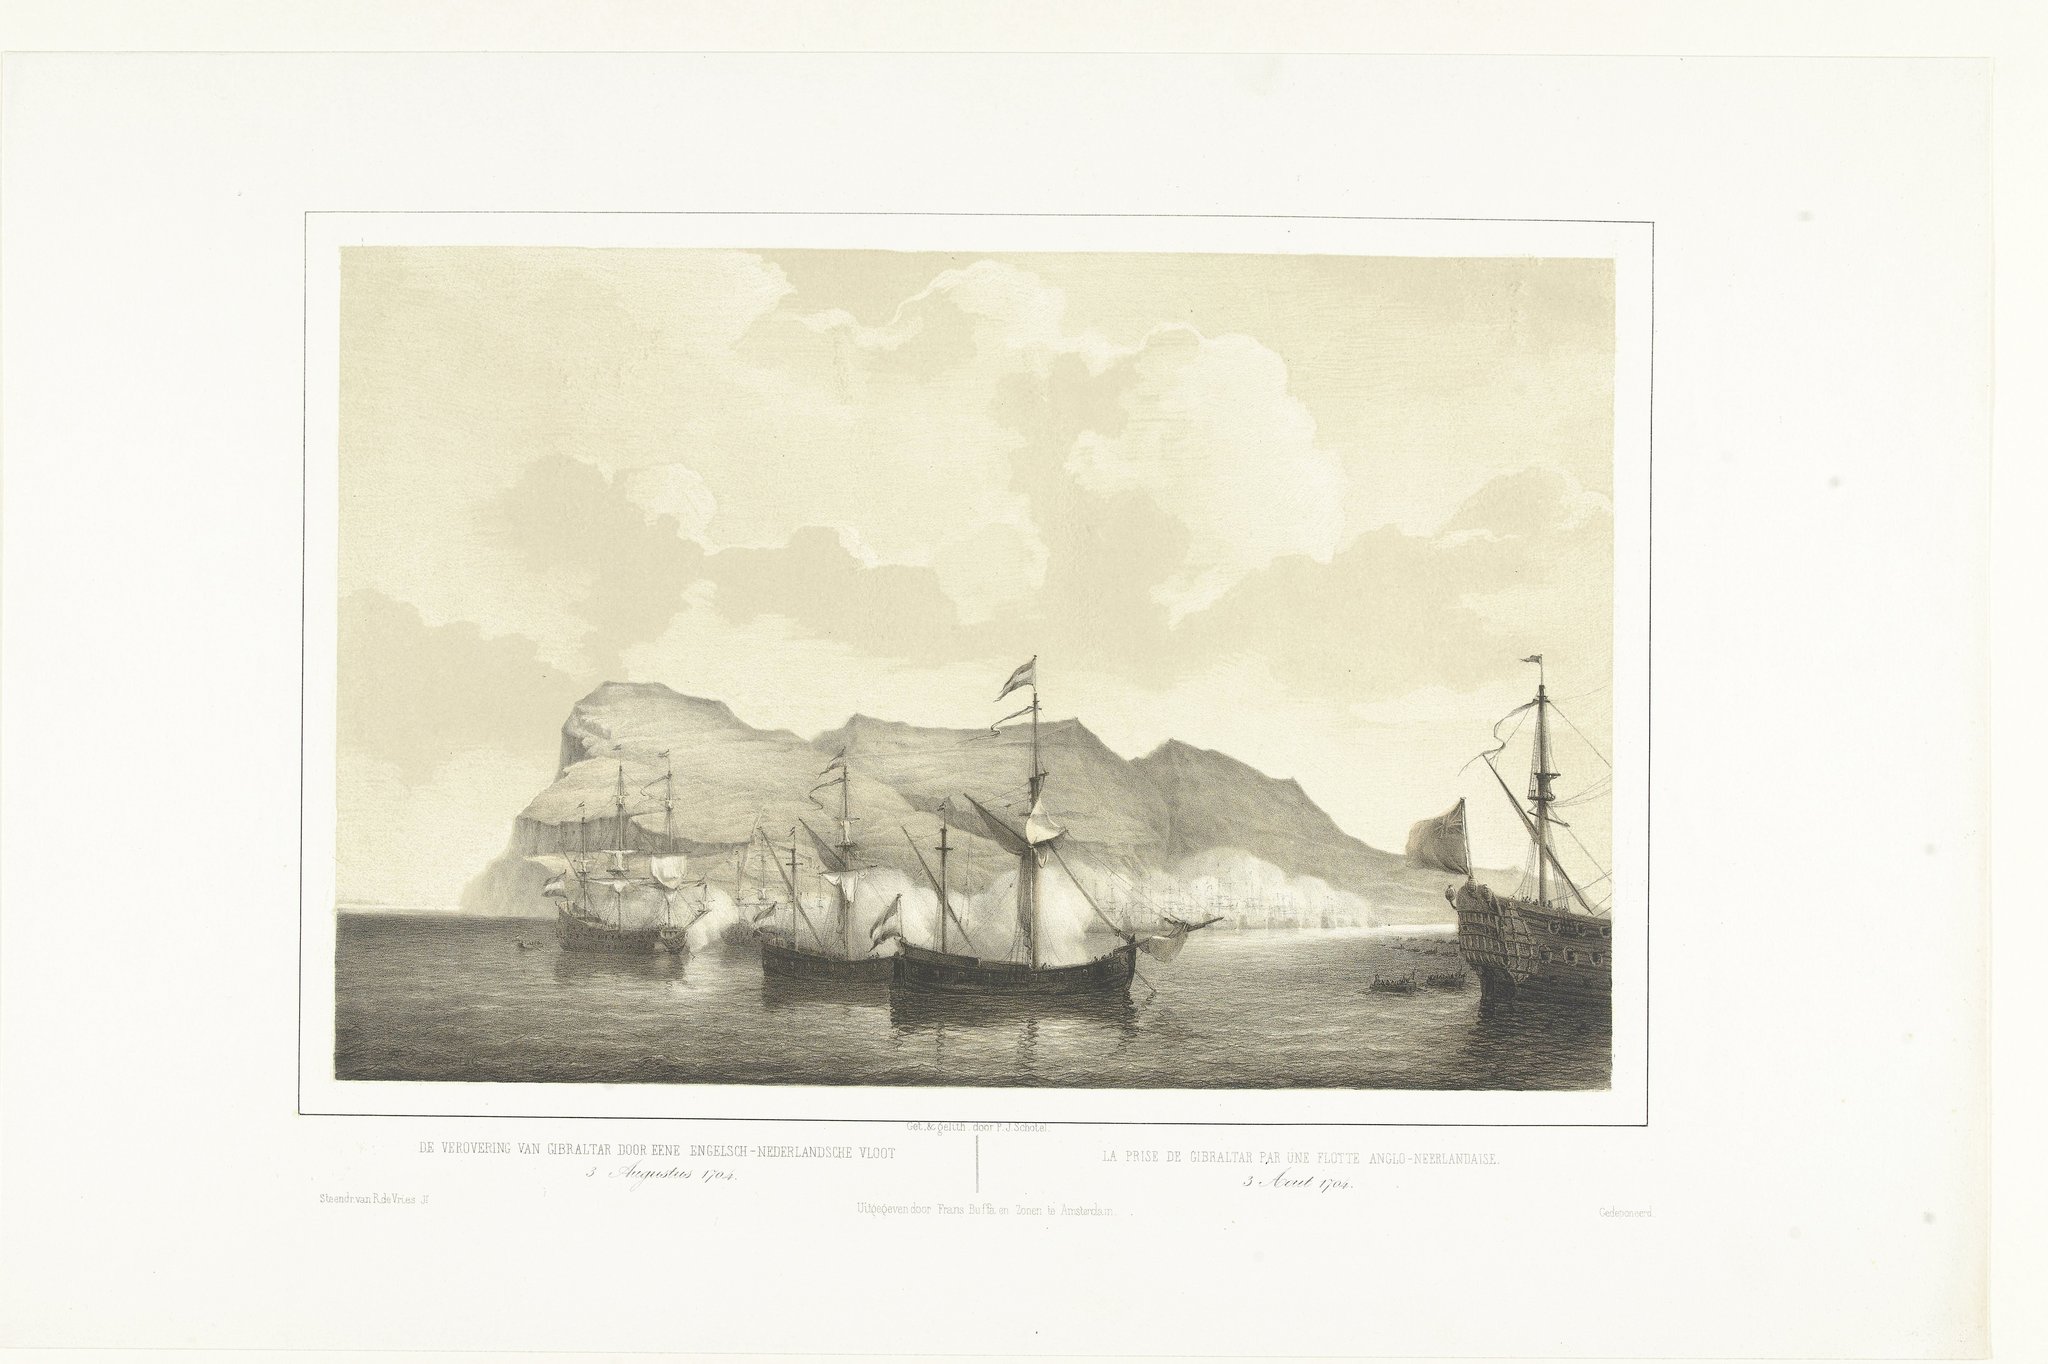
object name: print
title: De verovering van Gibraltar door eene Engelsch-Nederlandsche vloo. 3 Augustus 1704 / La prise de Gibraltar par une flotte Anglo-Neerlandaise. 3 Aout 1704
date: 1848-1855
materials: paper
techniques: lithograph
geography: amsterdam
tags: battle (+ naval force)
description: Uitgegeven in: P.J. Schotel, Heldendaden der Nederlanders ter zee, van de vroegste tijden tot op heden, naar aanleiding van de: Geschiedenis van het Nederlandsche zeewezen, Frans Buffa en Zonen, Amsterdam 1850-1855, pl. 40. Zonder de bij Muller vermelde bijgevoegde beschrijving.